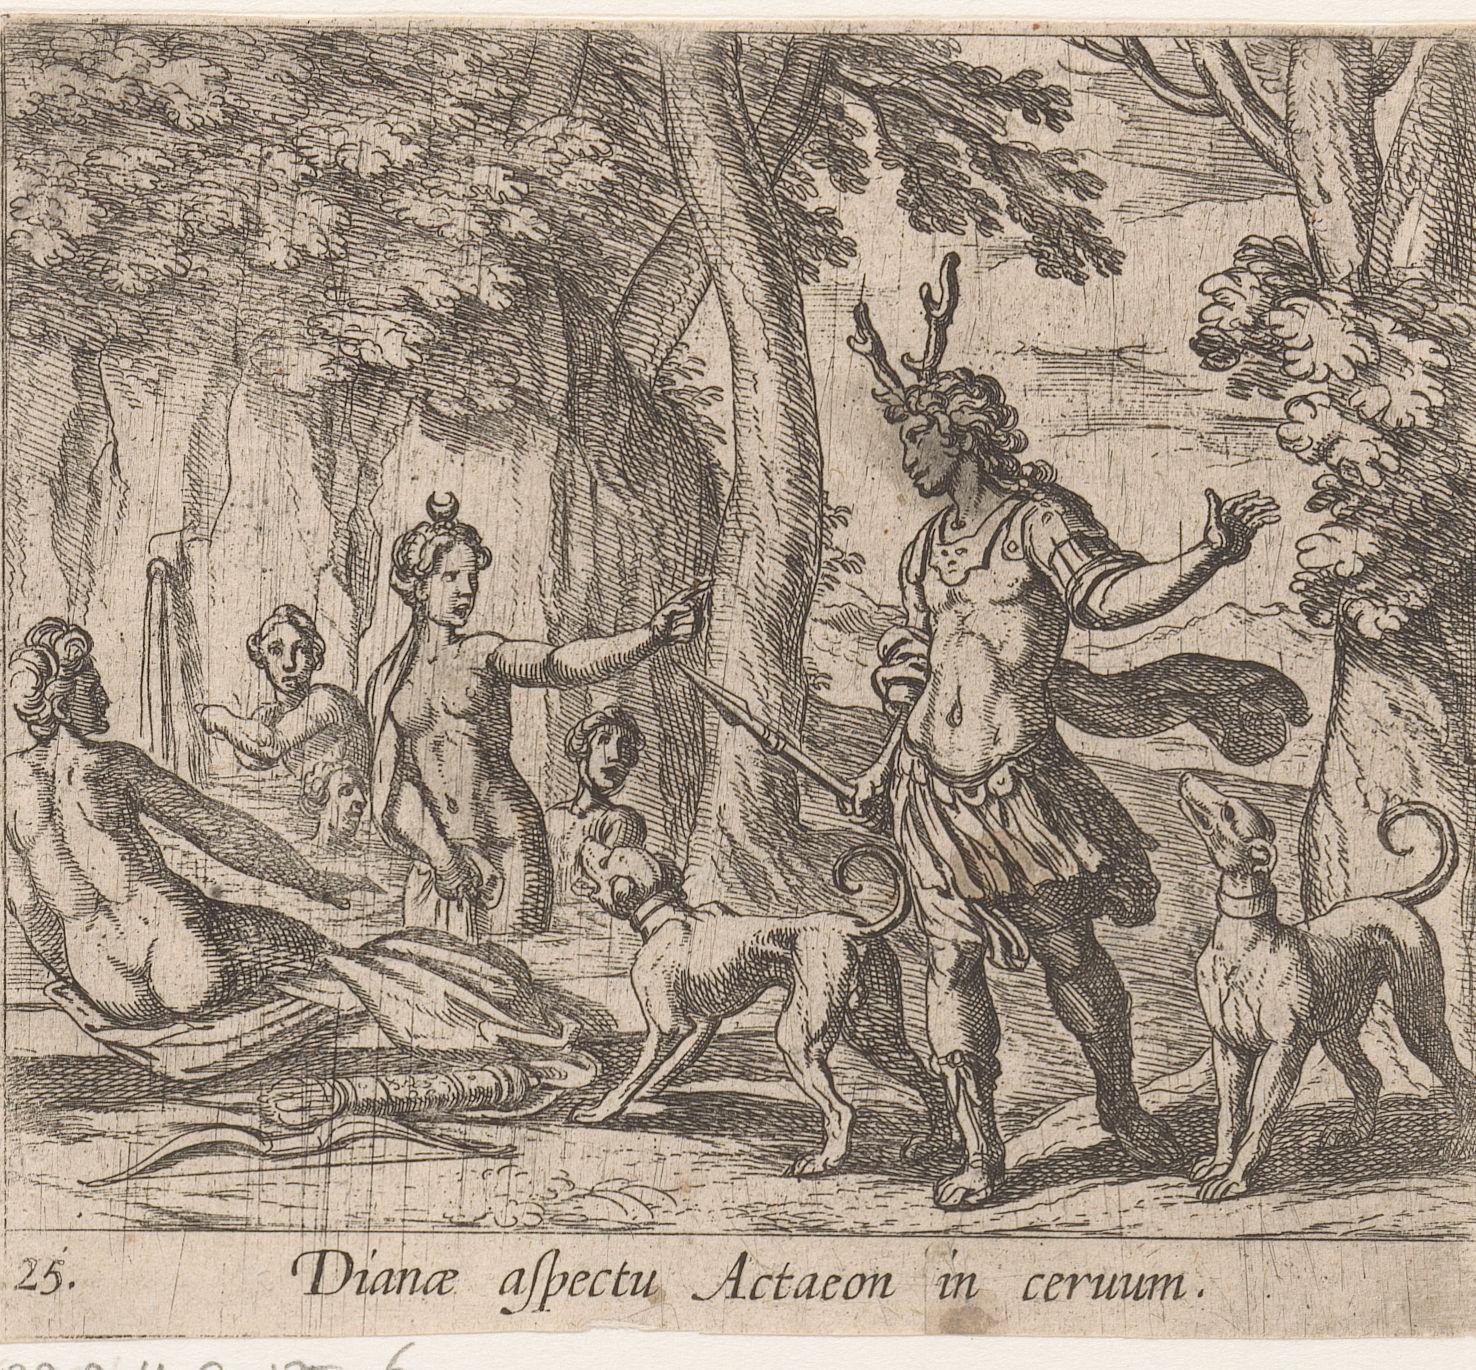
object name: print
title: Metamorphoseon sive transformationum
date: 1606-1638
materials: paper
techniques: etching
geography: italy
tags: hoofed animals: deer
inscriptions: collector's mark: ‘Hinloopen’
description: Boslandschap met Diana en haar nimfen die baden in een waterpoel. Actaeon staat de nimfen te begluren en wordt voor straf in een hert veranderd. Actaeon krijgt een gewei. Titel in het Latijn in ondermarge.